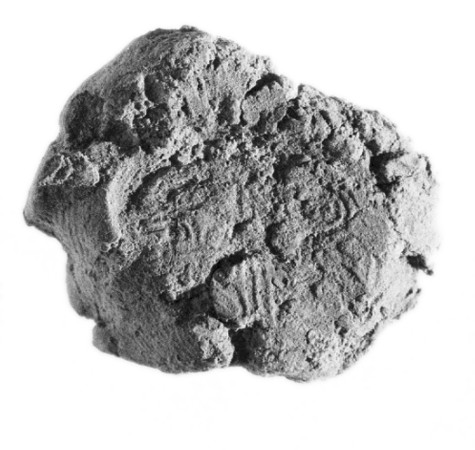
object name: sealing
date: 1981-1640 BCE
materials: mud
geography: egypt